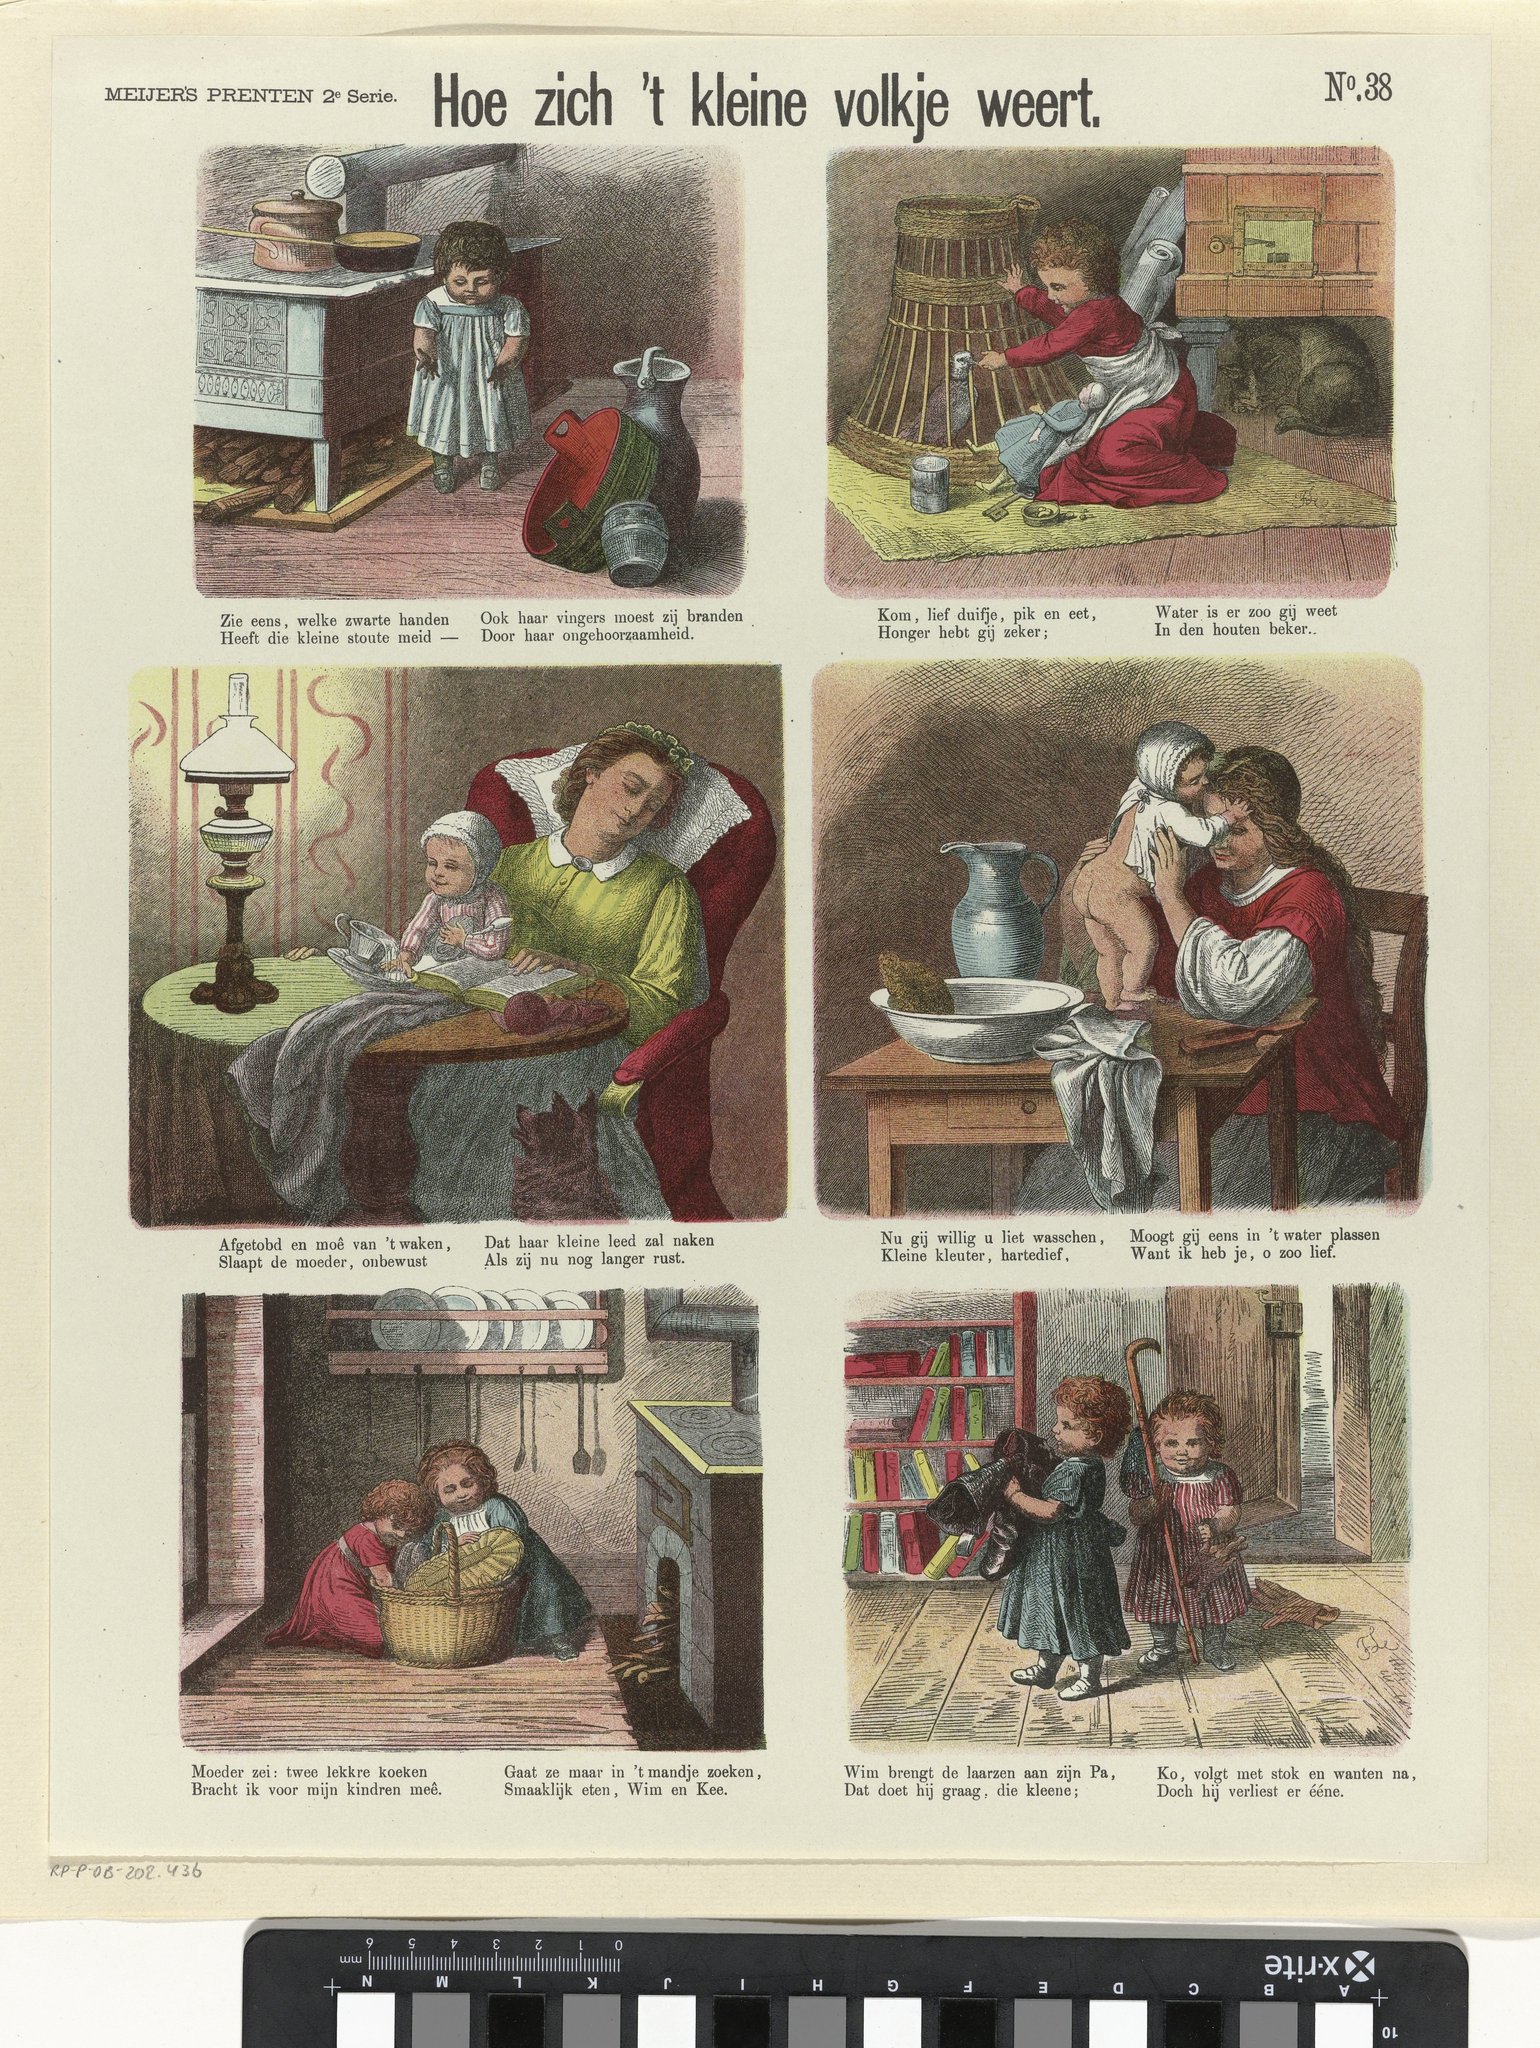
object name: popular print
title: Meijer's prenten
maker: Anonymous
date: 1874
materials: paper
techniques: lithograph, letterpress printing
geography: amsterdam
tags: child, parental love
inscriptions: collector's mark: Lugt 2760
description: Blad met 6 voorstellingen van kinderen, waaronder een meisje met zwarte handen, een kind met een duif, een slapende moeder met kind en twee kinderen met vaders stok en laarzen. Onder elke afbeelding een vierregelig vers in twee kolommen. Genummerd rechtsboven: No. 38.